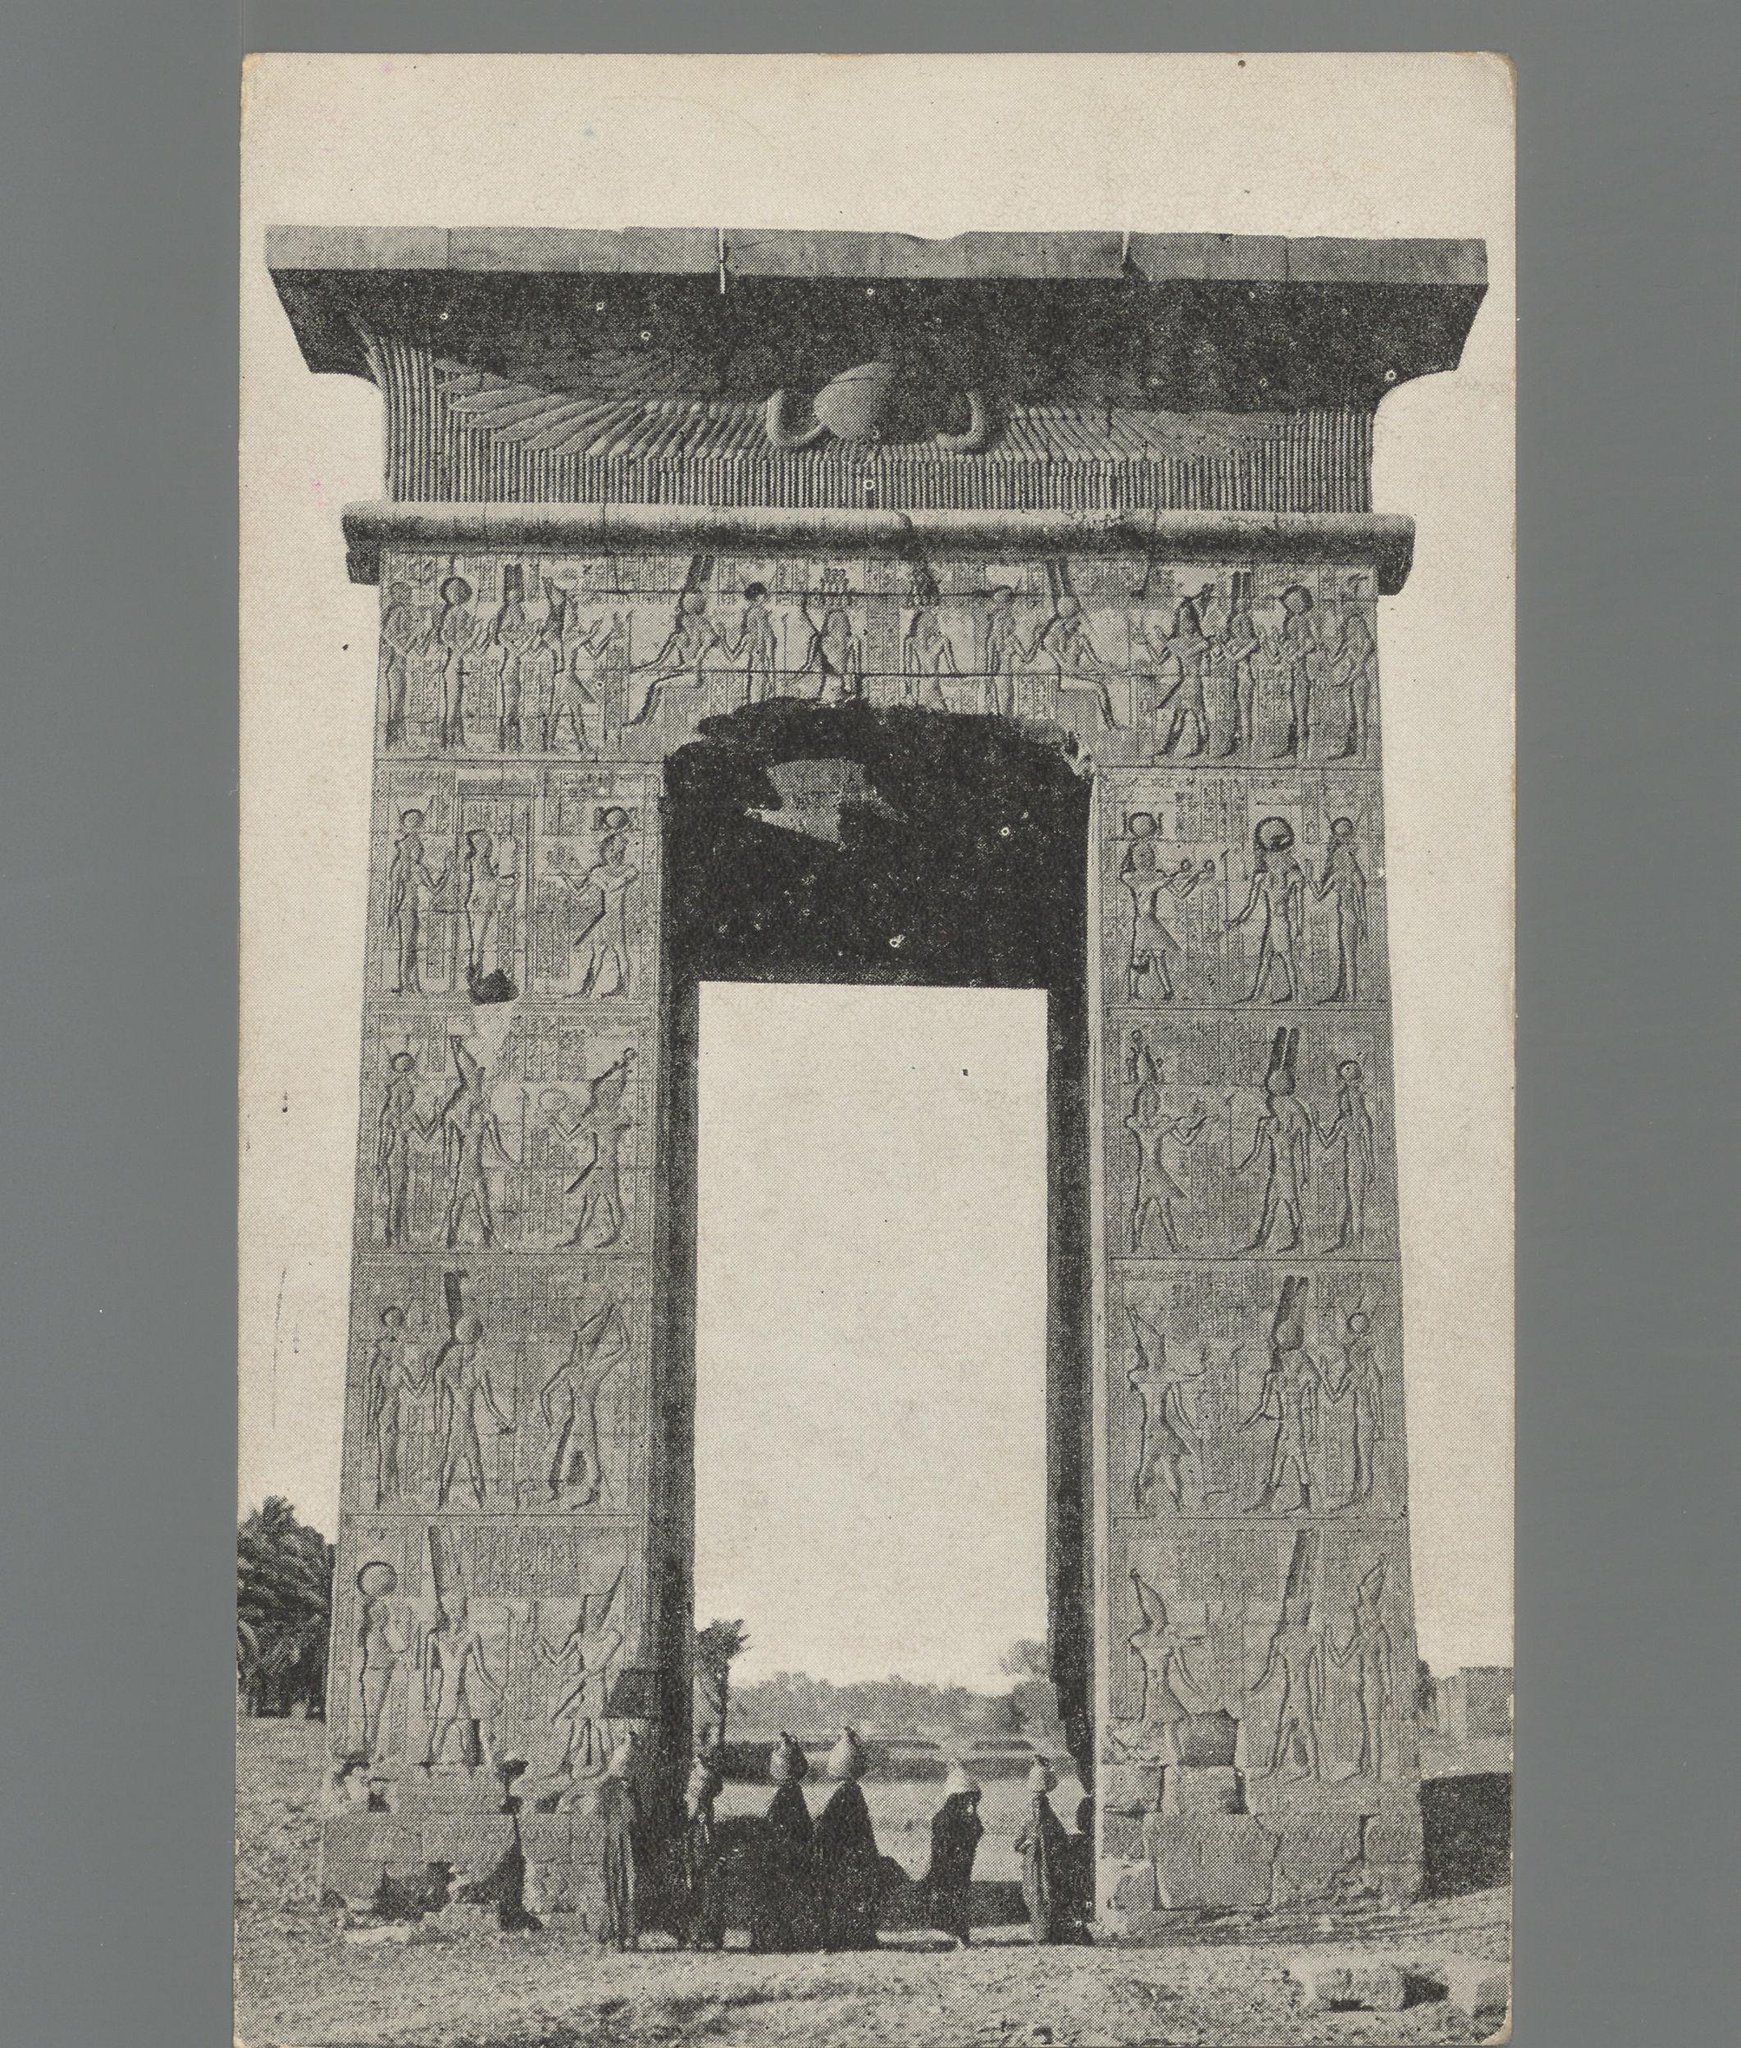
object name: photomechanical print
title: Karnak. North Ptolomey gateway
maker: Anonymous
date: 1907-1925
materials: cardboard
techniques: writing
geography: luxor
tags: gate, entrance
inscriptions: postage stamp